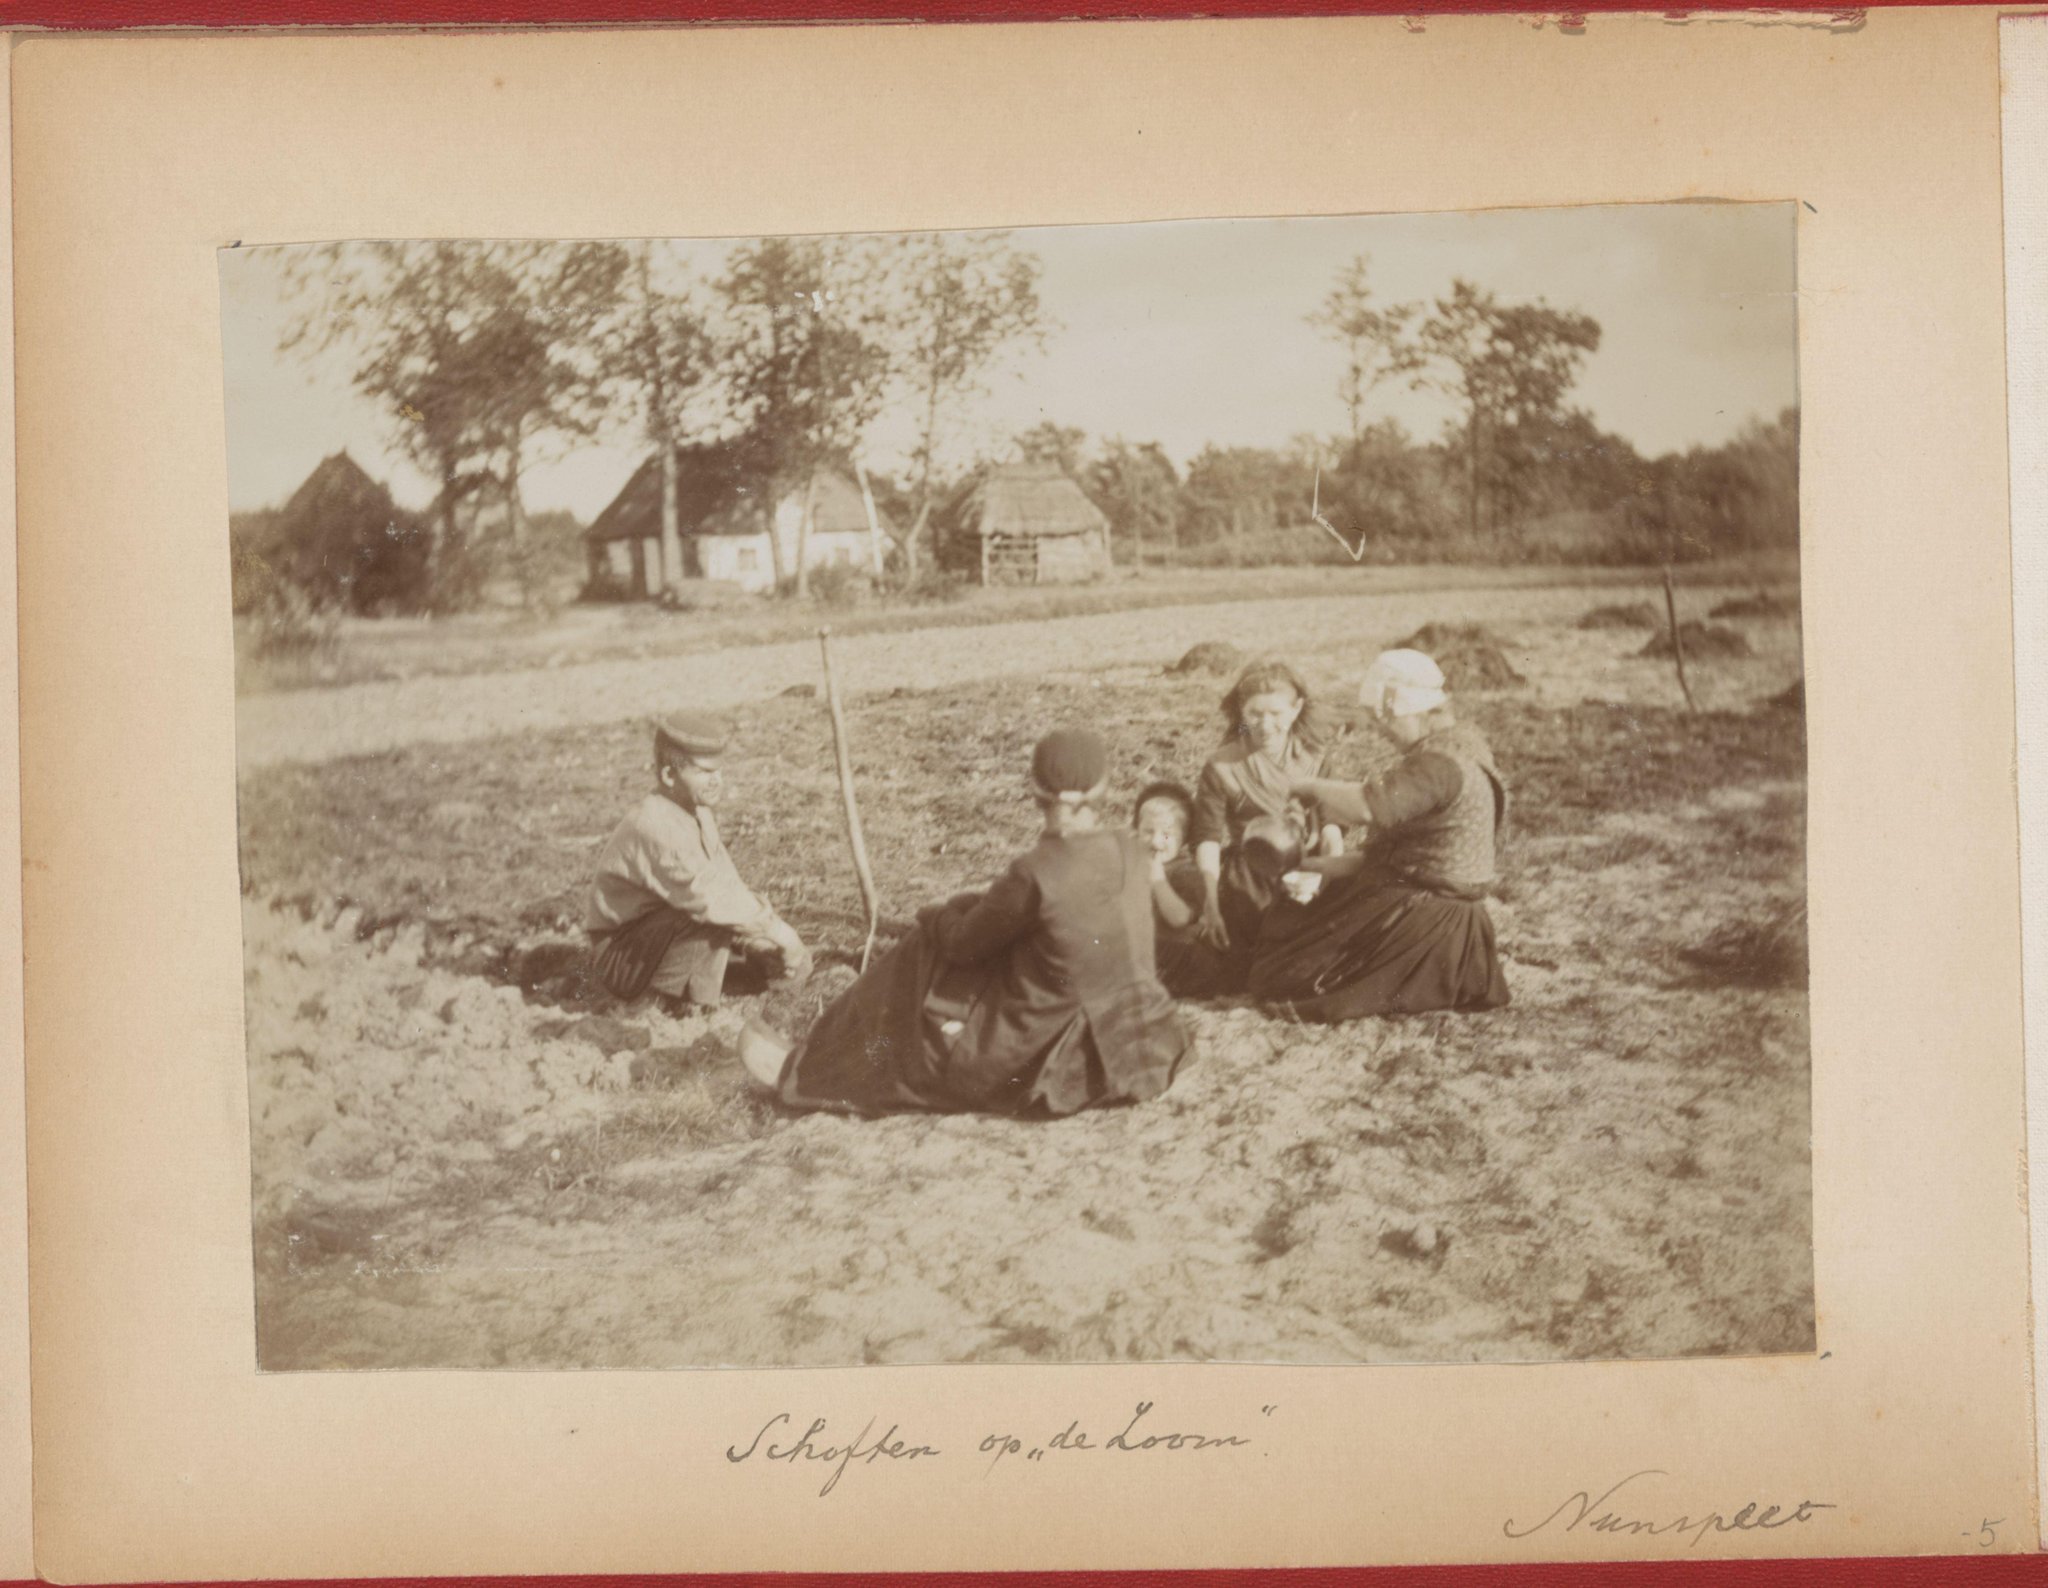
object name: photograph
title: Schaften op "de Zoom", boerengezin tijdens de schaft op het land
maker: gerard aalbersberg (us)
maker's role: amateurfotograaf, arts, chirurg, gynaecoloog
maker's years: 1870-1934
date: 1897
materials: paper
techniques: collodion silver print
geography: nunspeet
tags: nunspeet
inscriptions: : ‘Schaften op "de Zoom" Nunspeet’